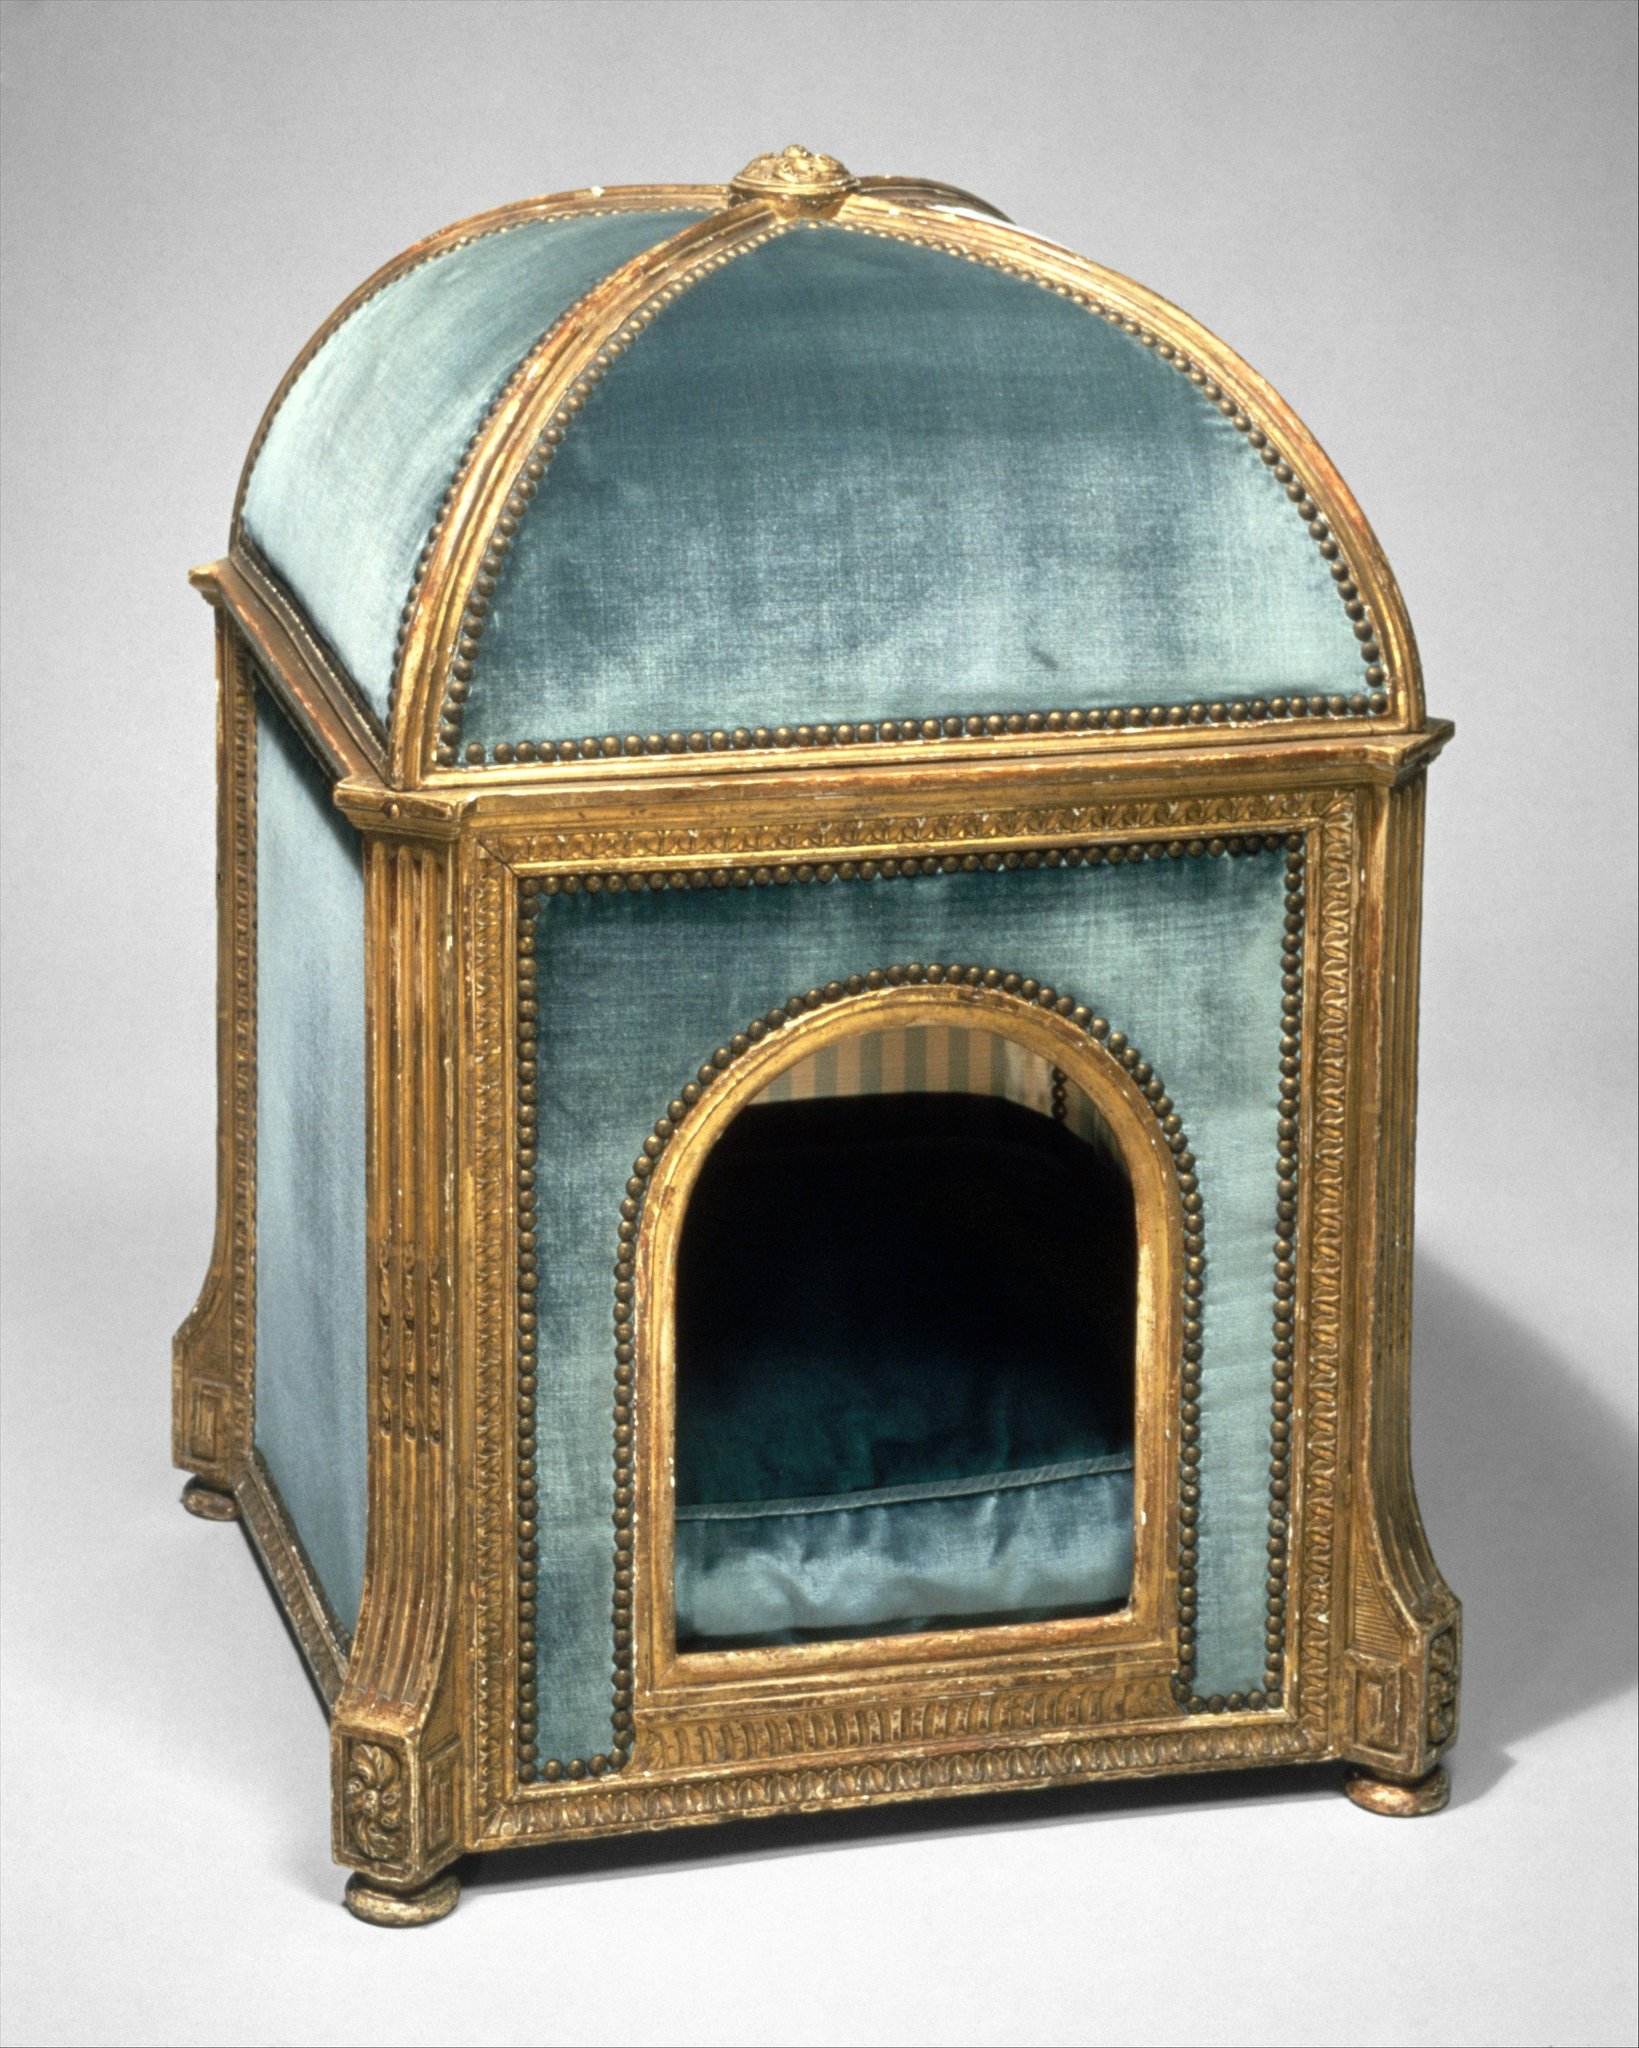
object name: kennel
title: Dog kennel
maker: claude i sené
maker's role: maker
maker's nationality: french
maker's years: 1724-1792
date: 1775-1780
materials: wood, silk, velvet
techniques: gilding